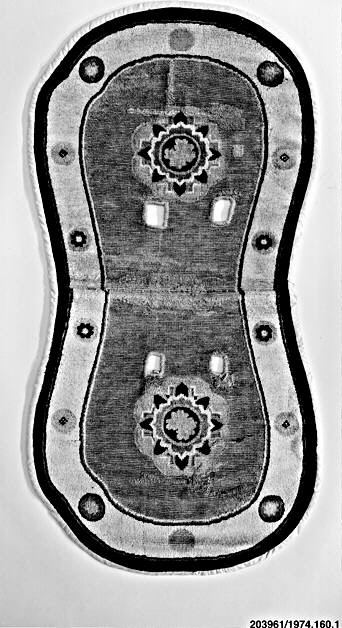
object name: rug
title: Saddle Rug with Rosette Roundels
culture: chinese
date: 1701-1900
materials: cotton, wool